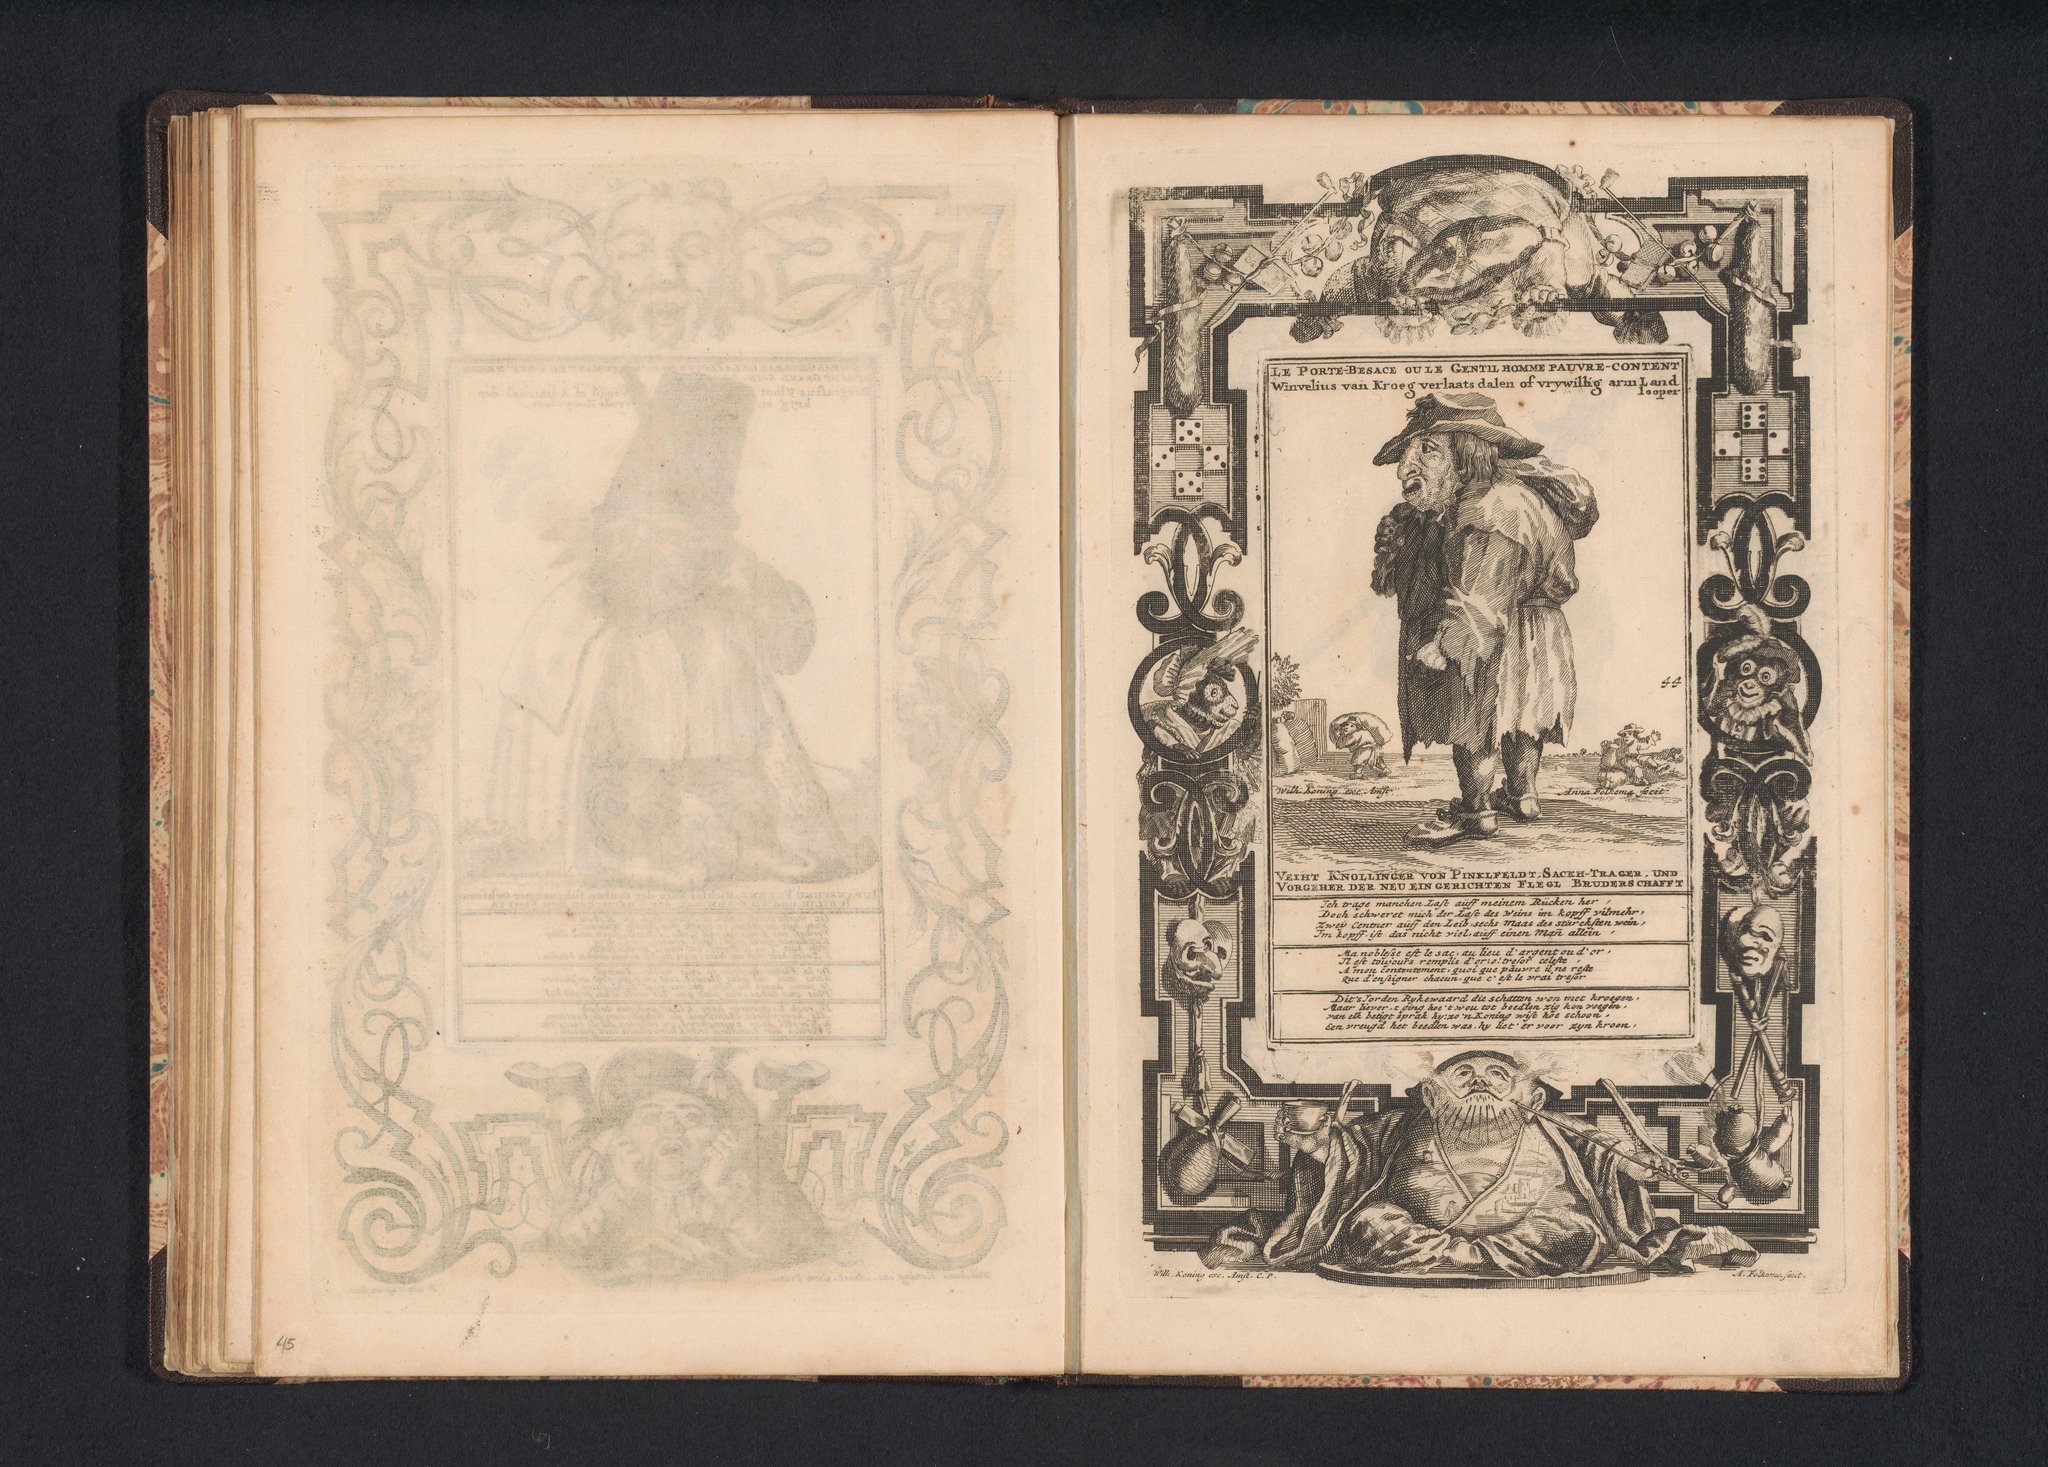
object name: print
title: De dwerg Winvelius van Kroeg verlaats dalen, 1716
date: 1716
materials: paper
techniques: etching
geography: northern netherlands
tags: caricatures (human types), opium-pipe, little people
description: De kleine mens Winvelius van Kroeg verlaats dalen, zakkendrager. In het onderschrift verzen in het Duits, Frans en Nederlands. Afdruk binnen een decoratieve omlijsting gedrukt van een aparte plaat met Chinese kleine mensen, onderaan een rokende kleine mens met een opiumpijp. Genummerd rechts midden: 44. Onderdeel van de Nederlandse gebonden uitgave uit 1716 van een serie karikaturen van kleine mensen, bekend als Het Dwergentooneel, gekopieerd naar een ouder Duits voorbeeld.